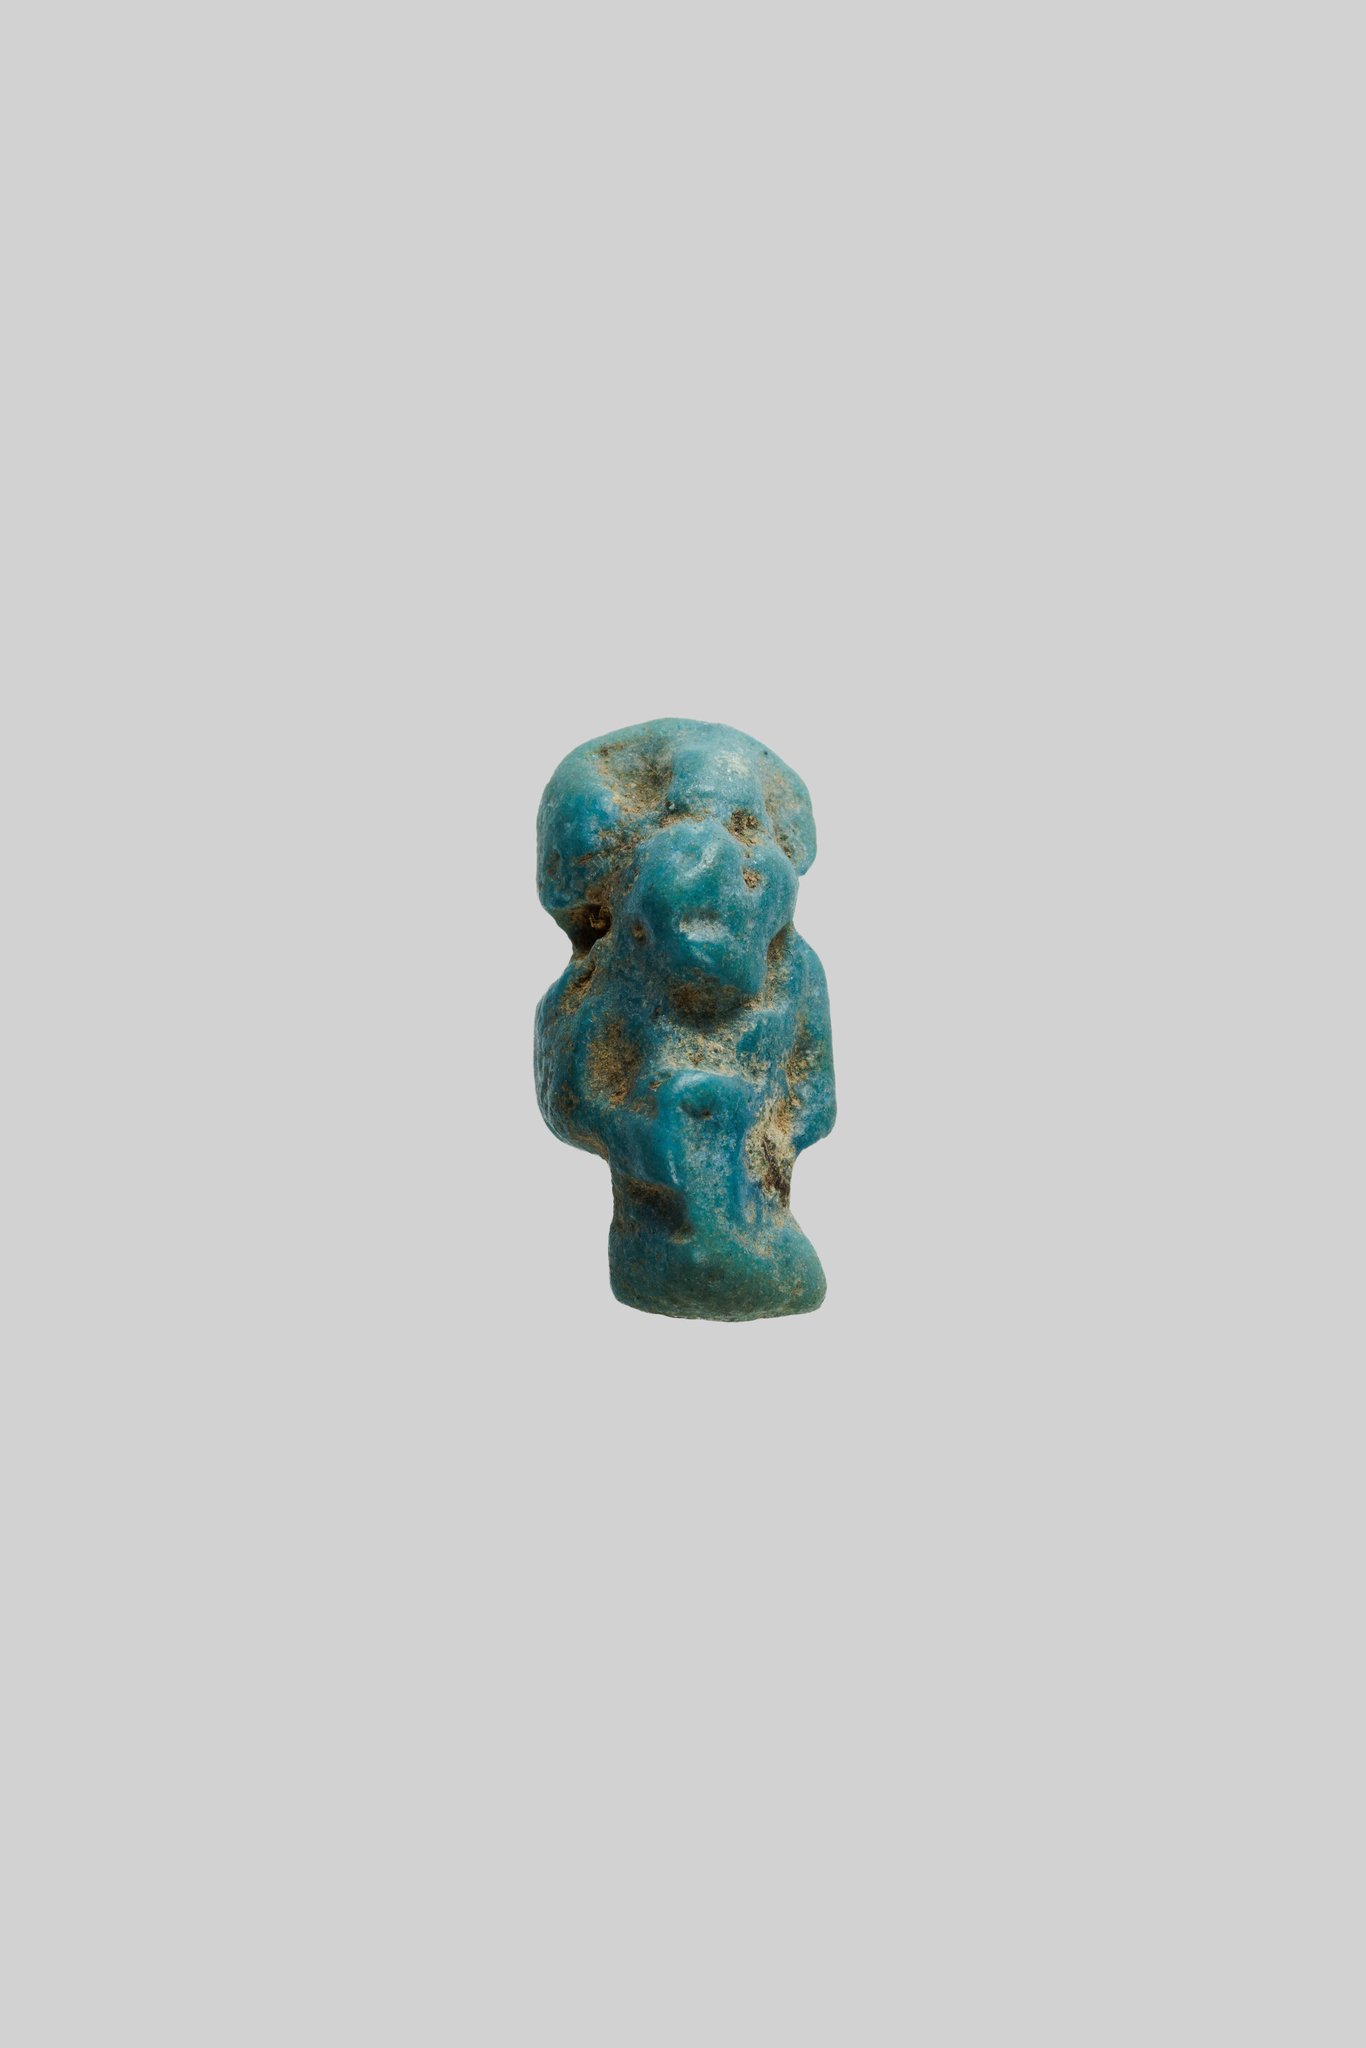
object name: amulet, sakhmet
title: Sakhmet amulet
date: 1295-1070 BCE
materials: faience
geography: egypt